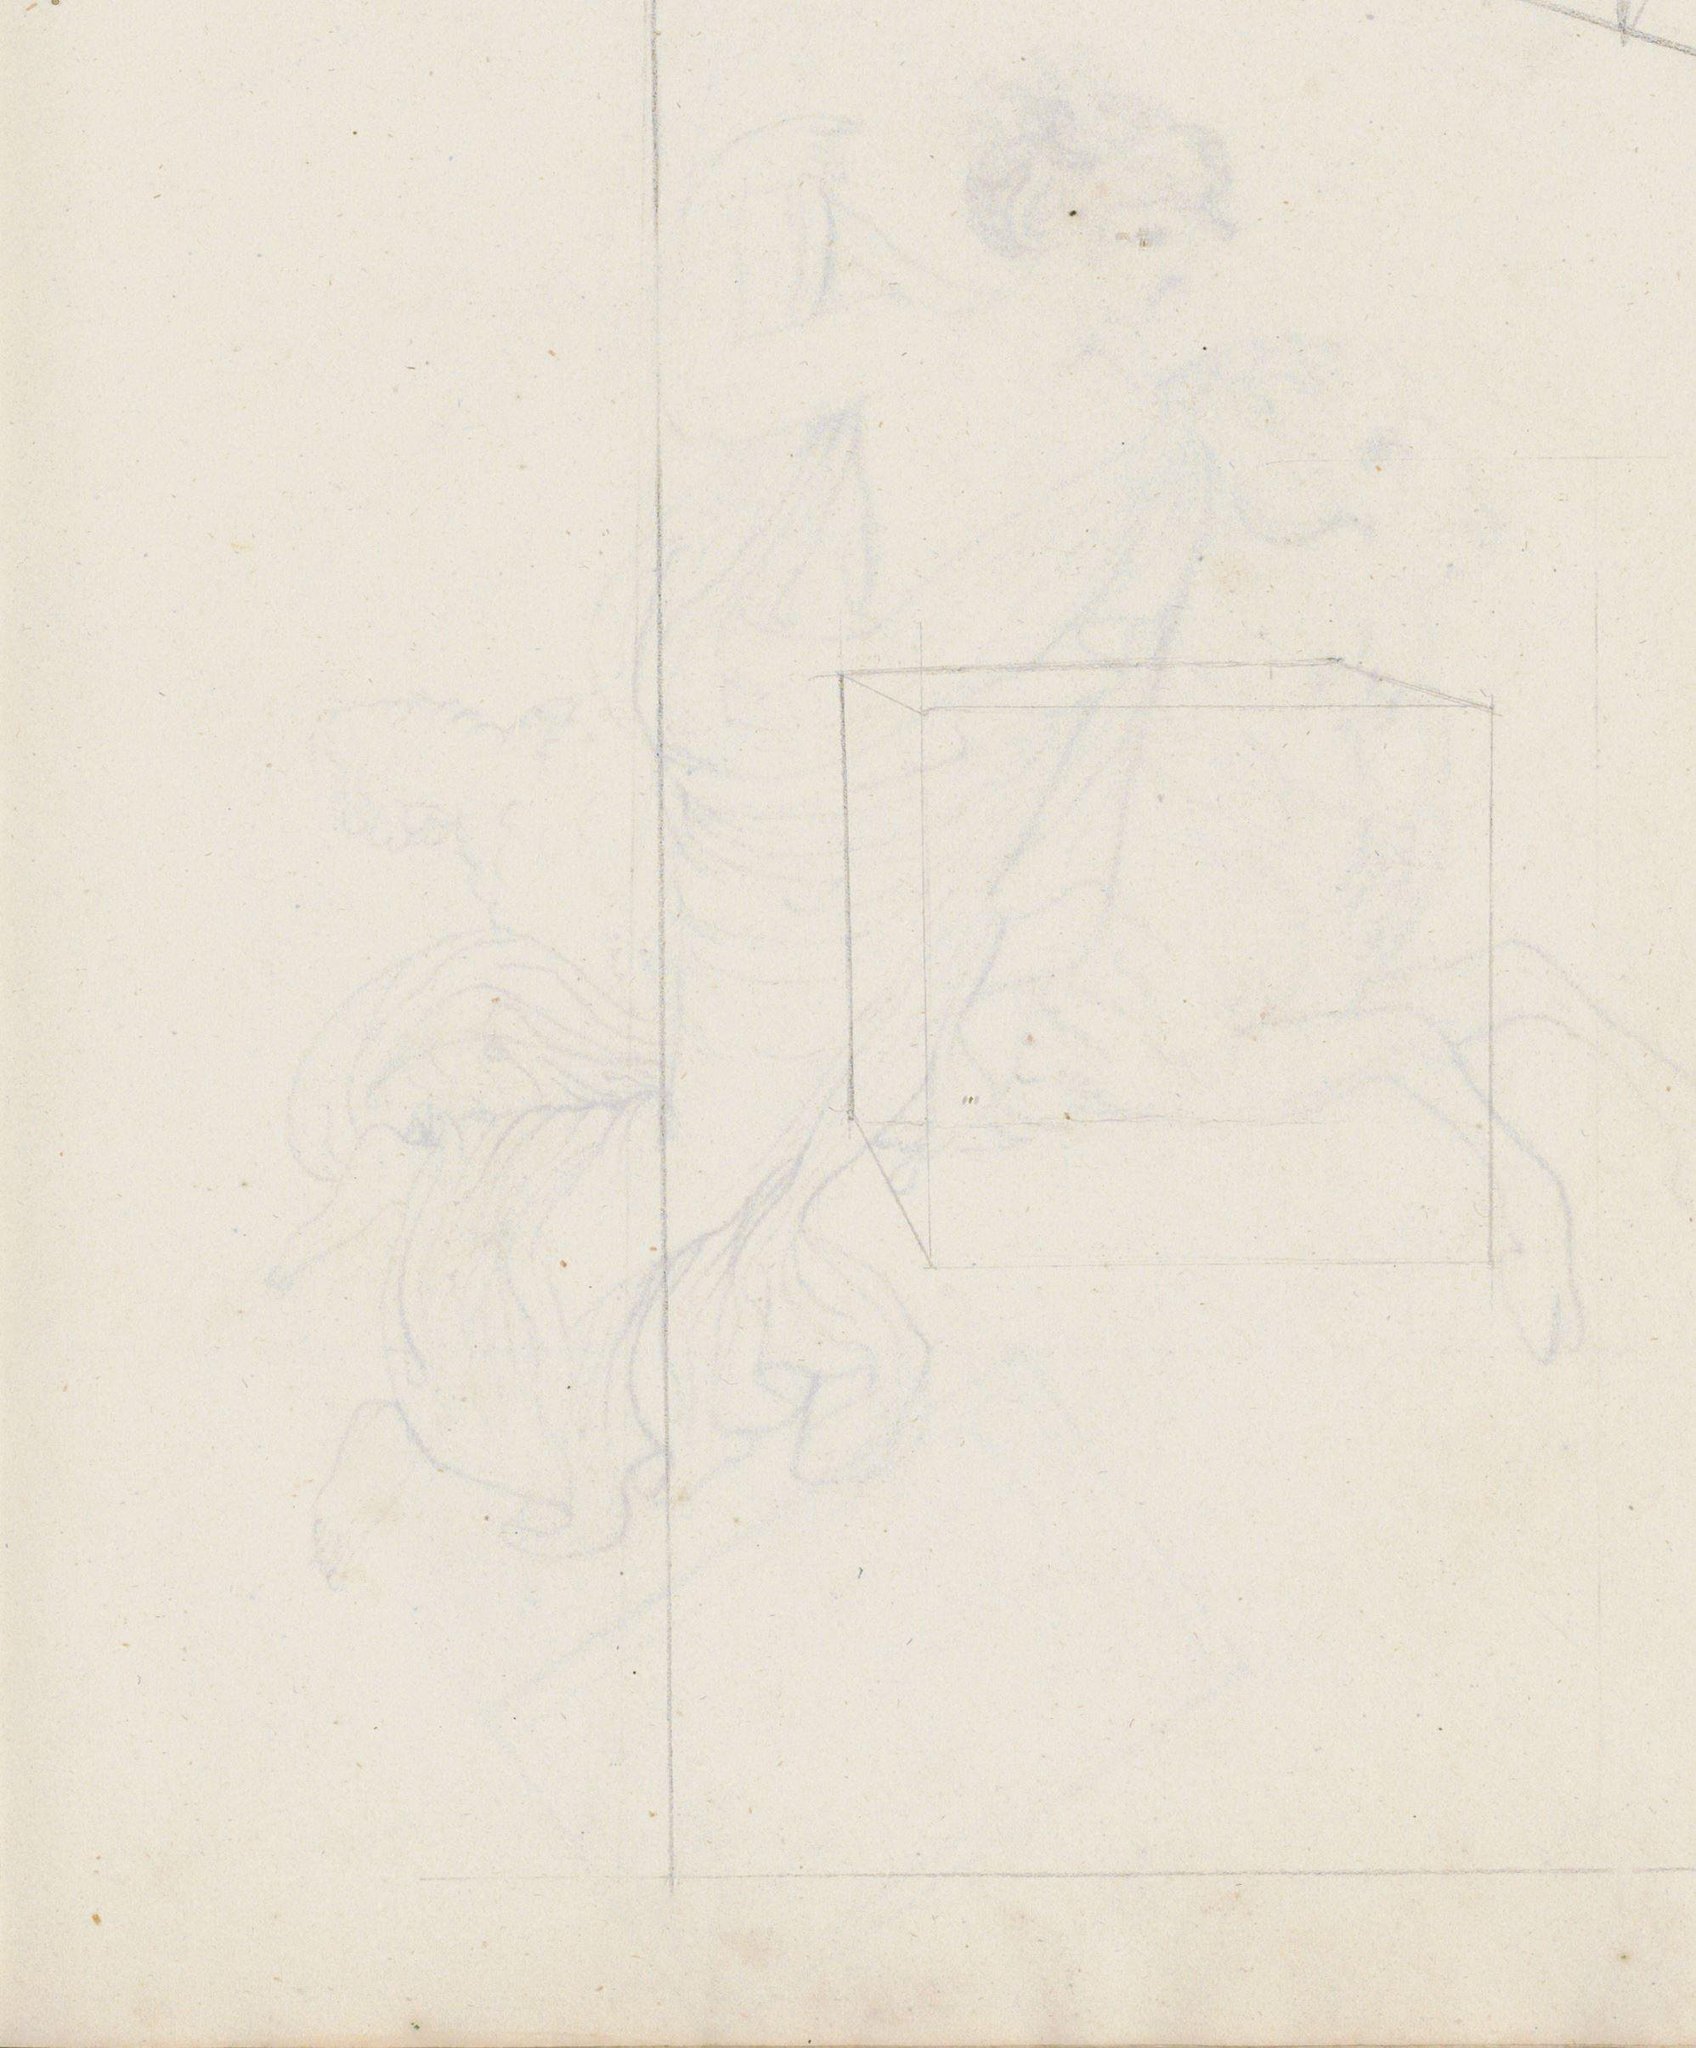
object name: sketchbook leaf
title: Perspectiefoefening met een kubus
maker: jonkvrouw catharina kemper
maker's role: draughtsman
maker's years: 1801-1871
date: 1813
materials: paper, pencil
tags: hexahedron, cube, mathematical perspective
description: Blad 28 recto uit een schetsboek met 91 bladen.